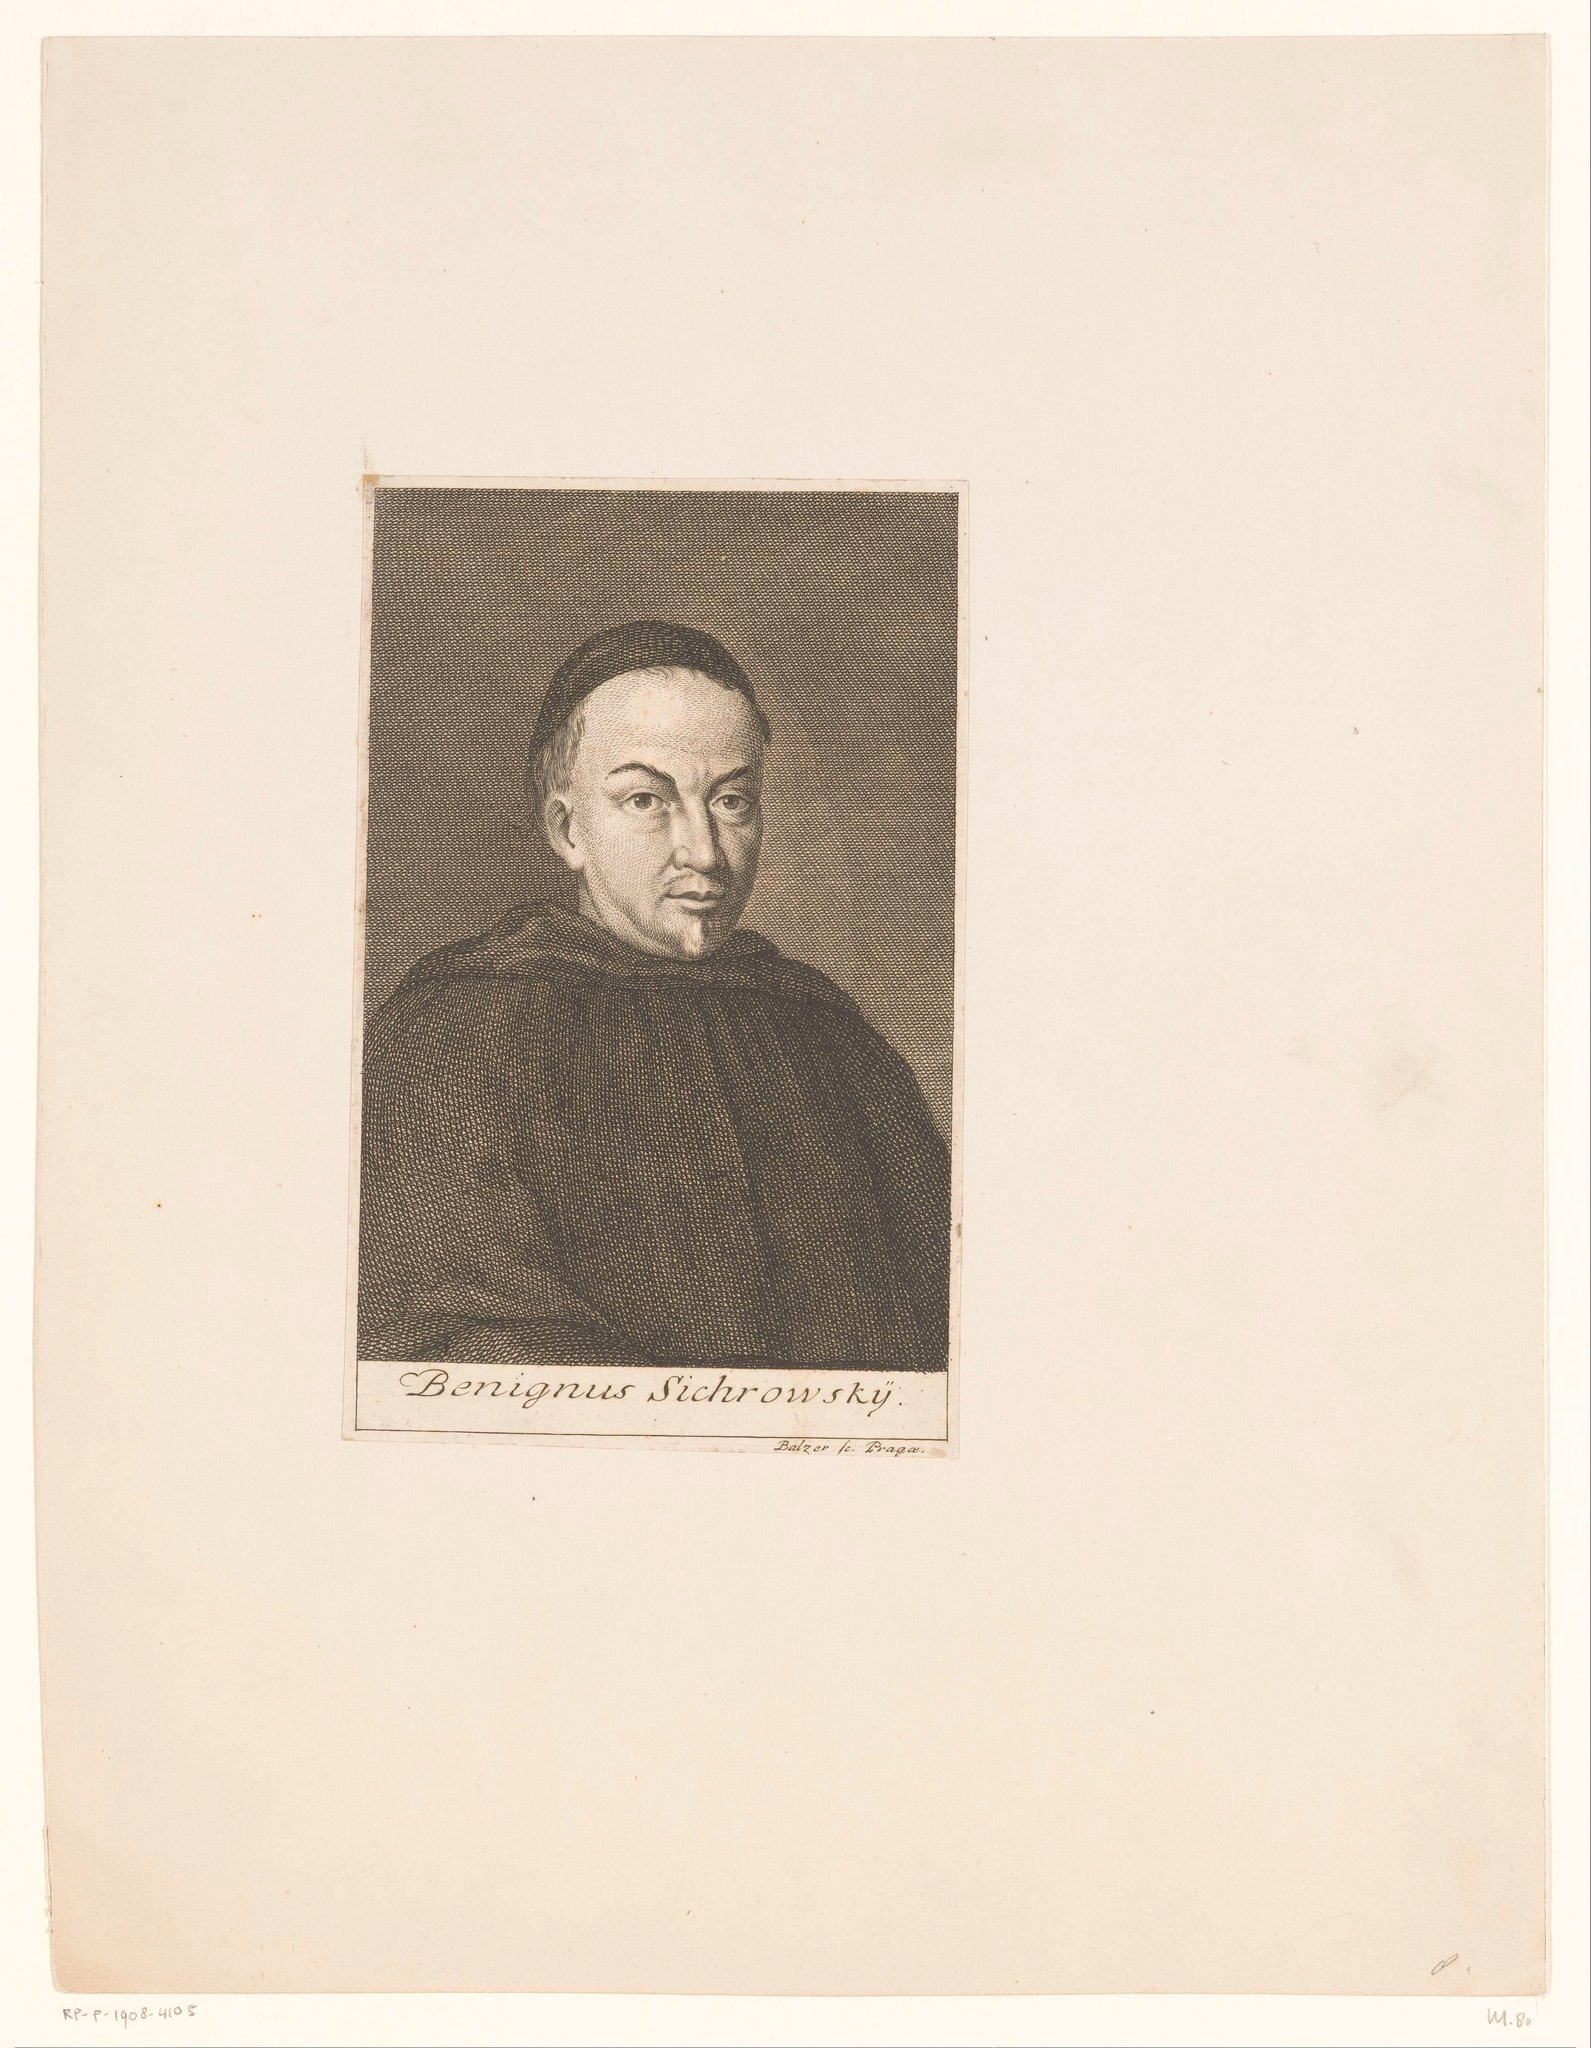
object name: print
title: Portret van Benignus Sichrowsky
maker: jan balzer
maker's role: print maker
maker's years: 1736-1799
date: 1746-1799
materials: paper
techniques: engraving, etching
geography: prague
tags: historical persons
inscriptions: collector's mark: Lugt 2228